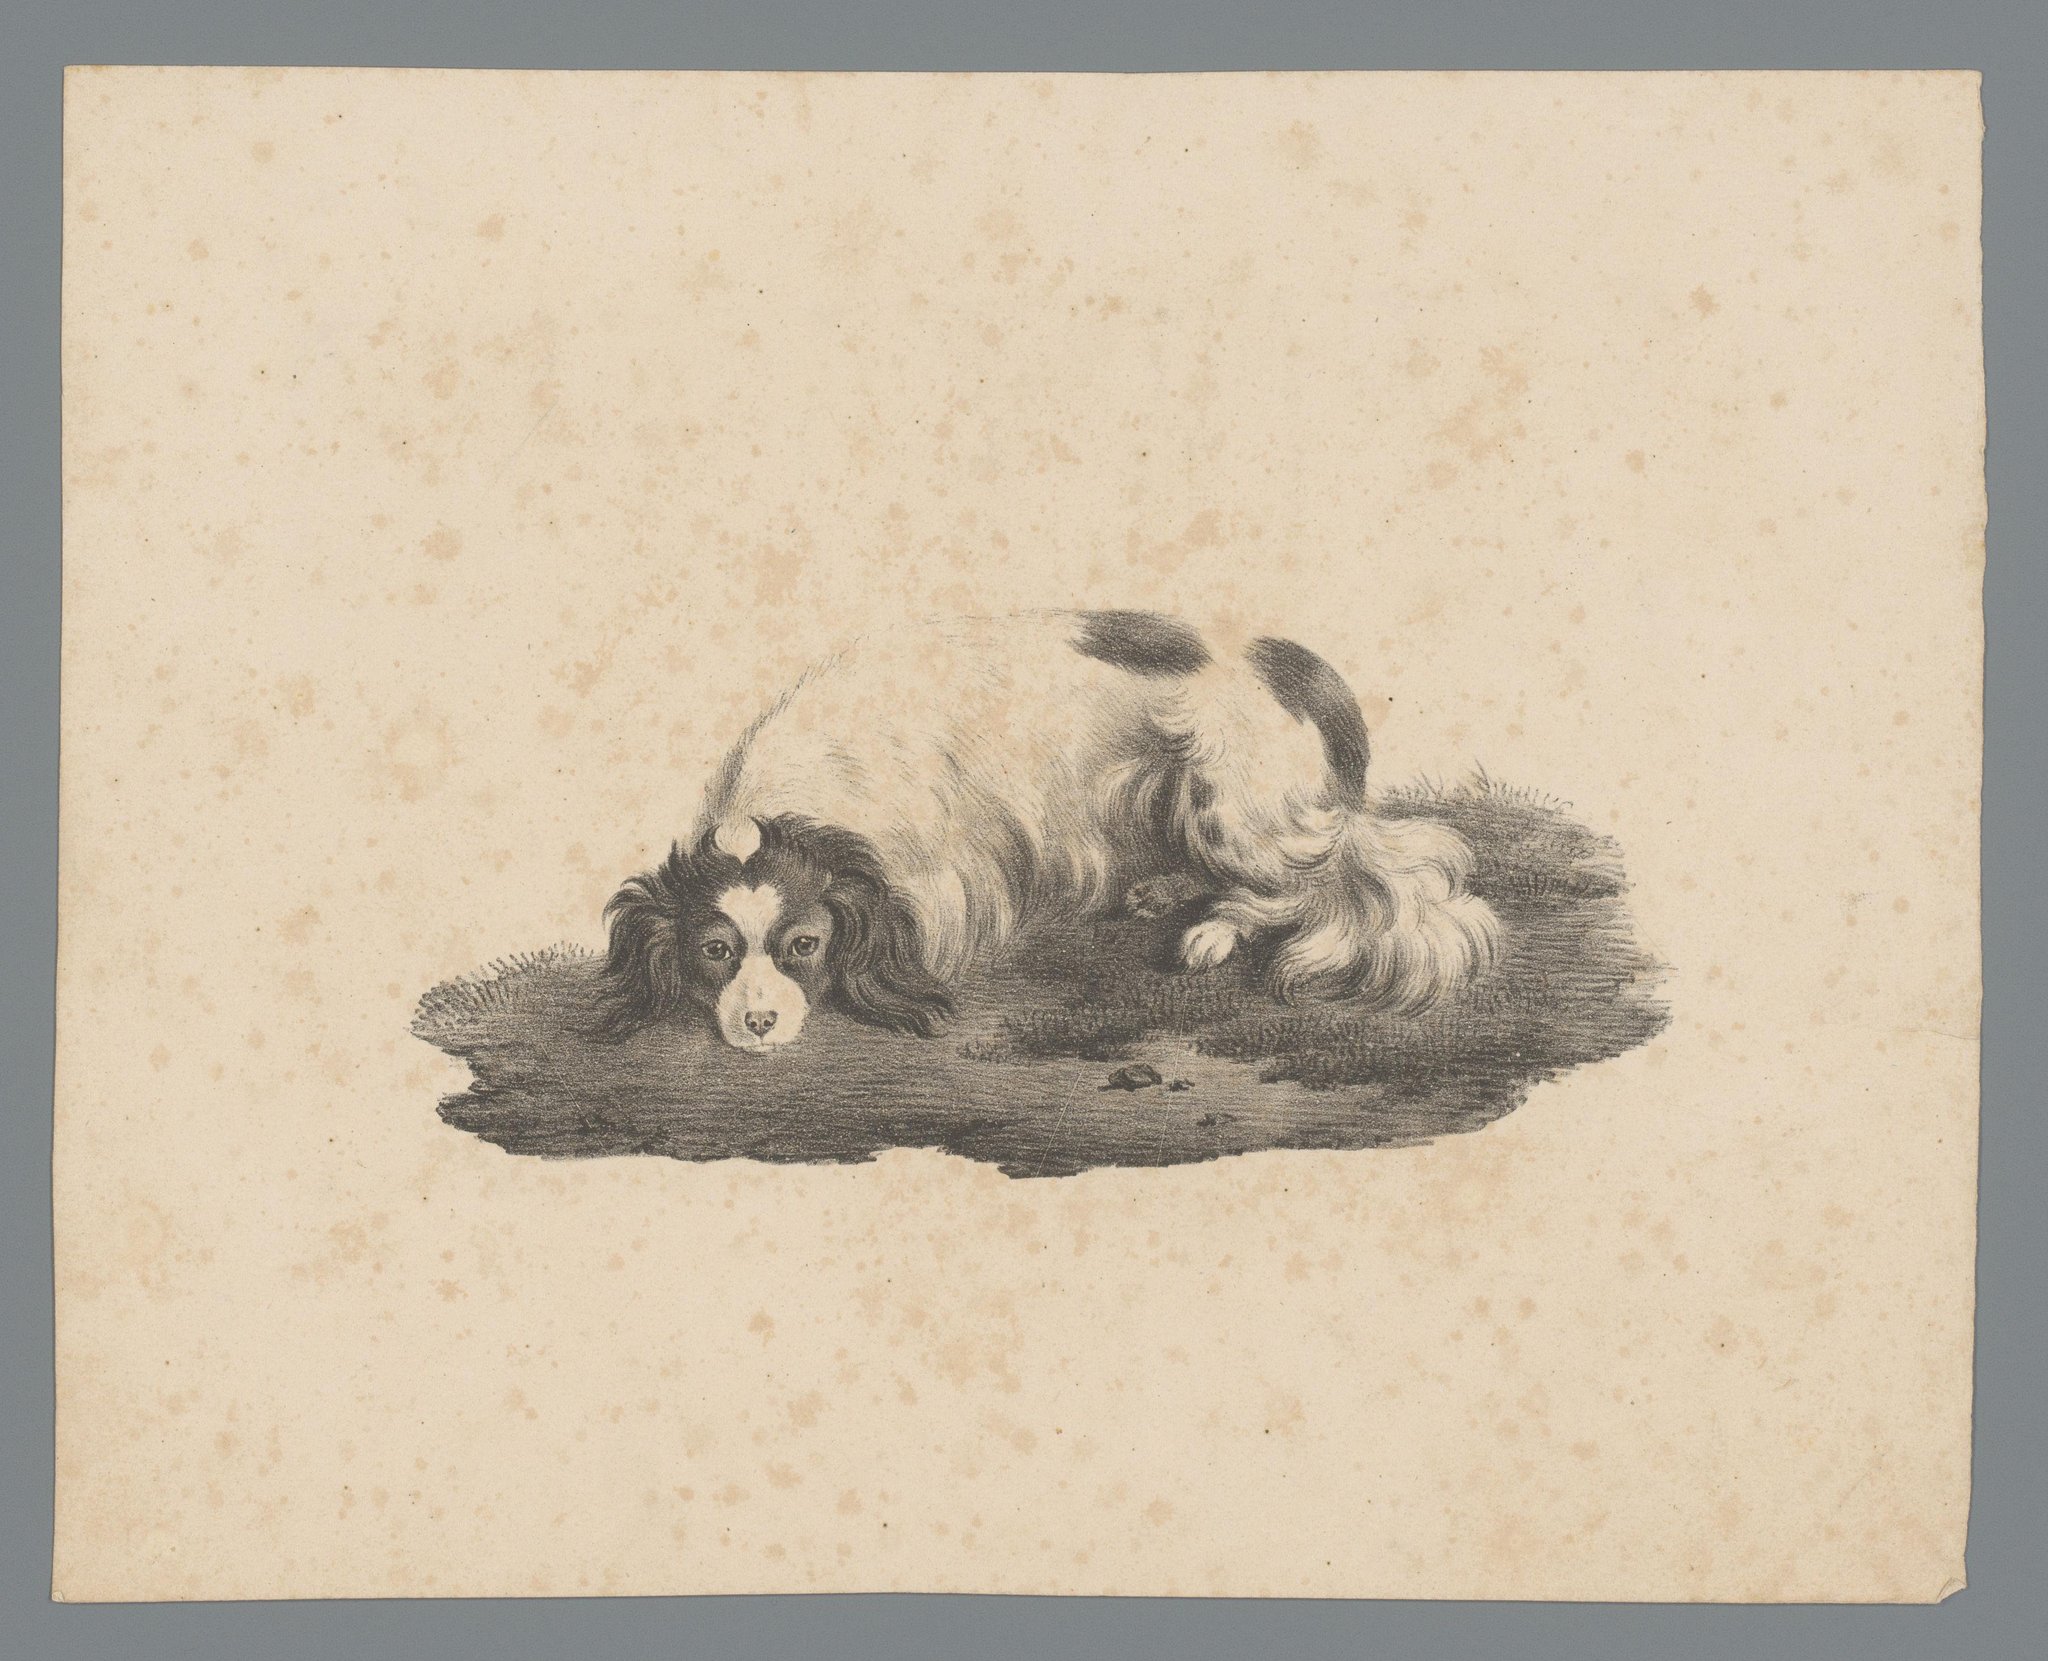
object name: print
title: Liggende hond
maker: p.j. rommel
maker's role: print maker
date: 1824-1827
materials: paper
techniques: lithograph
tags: dog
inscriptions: collector's mark: Lugt 2228